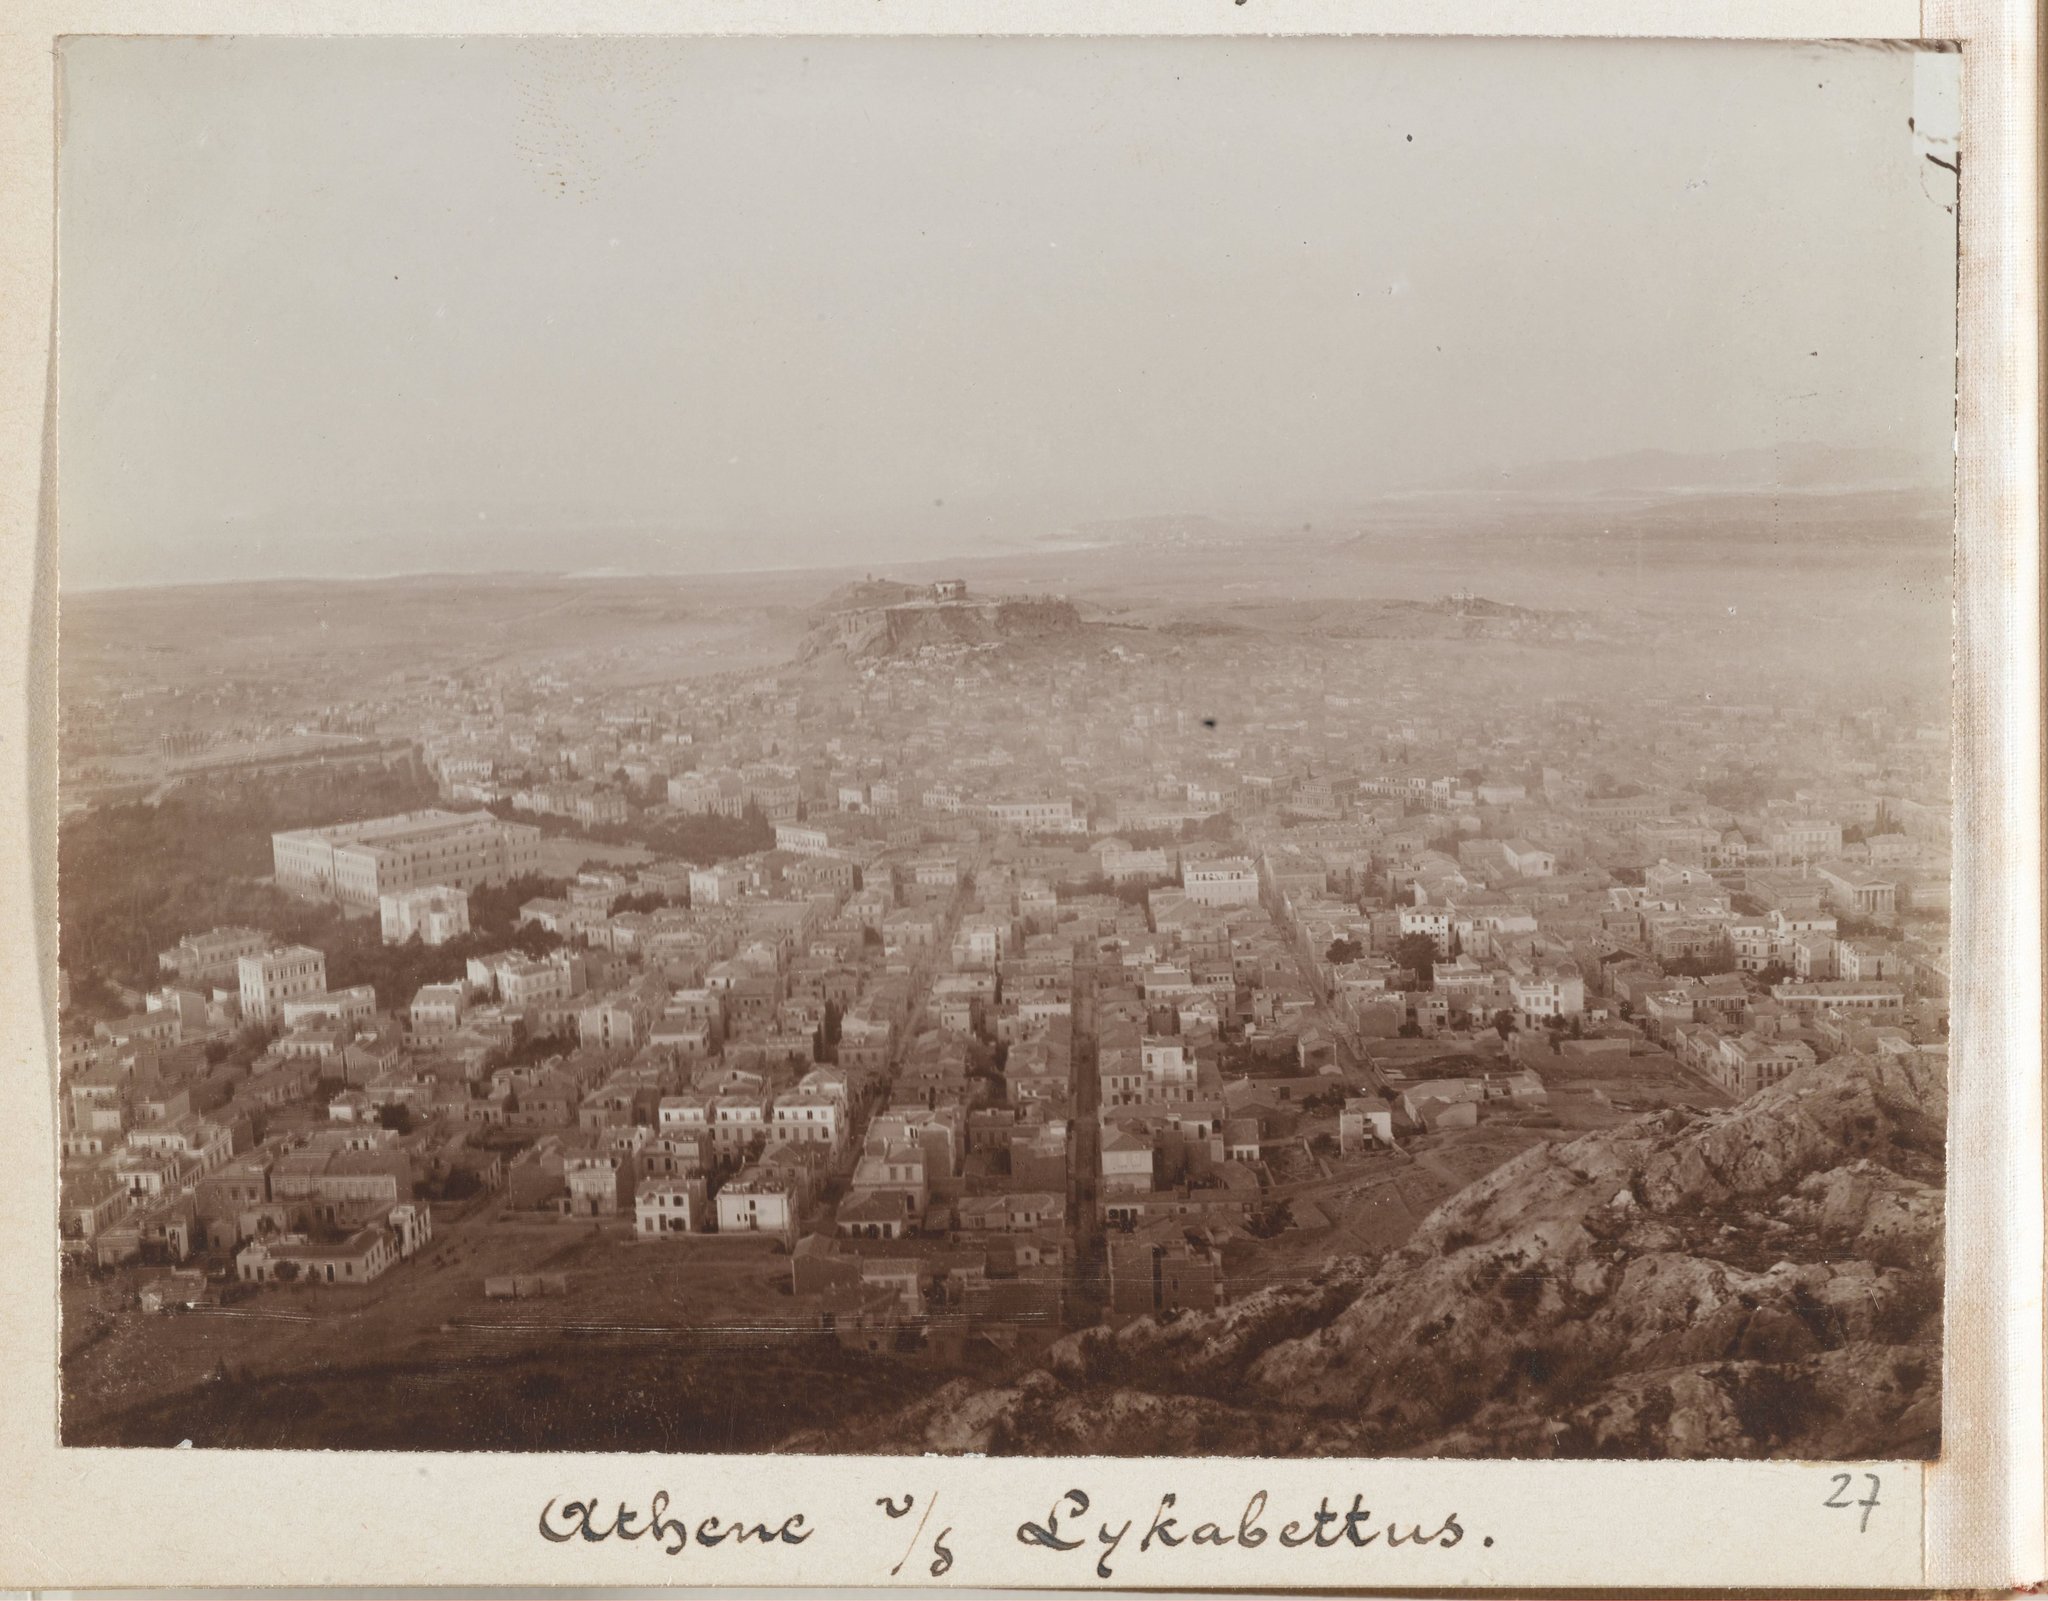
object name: page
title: Gezicht op Athene vanaf de Lycabettus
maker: johannes lodewijk heldring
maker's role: fotograaf, predikant, schrijver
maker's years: 1852-1923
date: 1898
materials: paper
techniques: collodion silver print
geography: athens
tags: city-view in general; 'veduta'